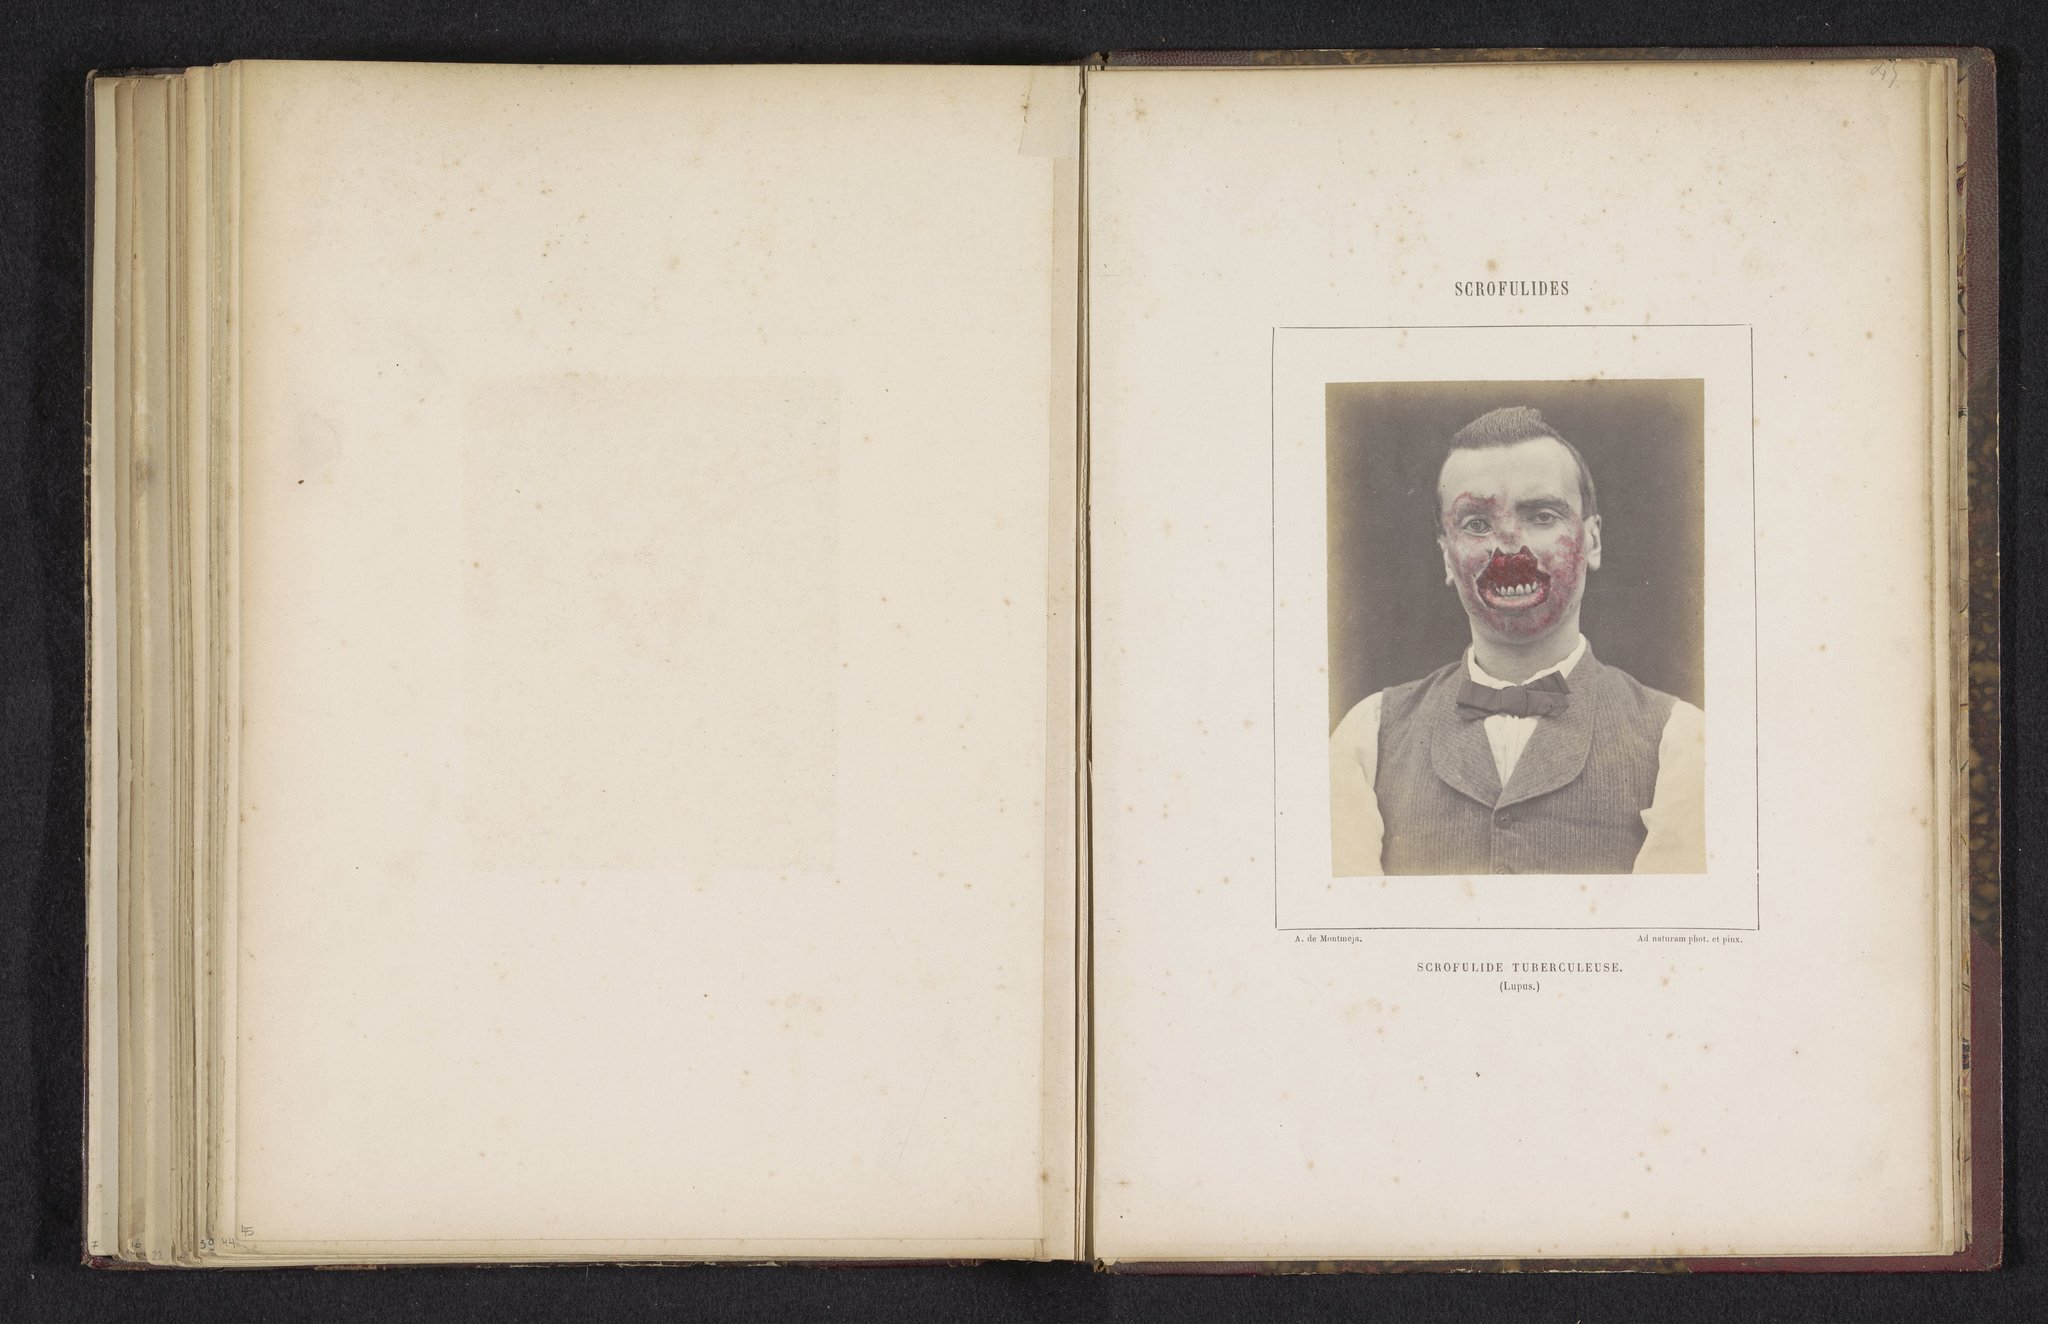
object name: page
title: Portret van een onbekende man met zweren in zijn gezicht en een missende neus en lip, mogelijk veroorzaakt door koningszeer en tuberculose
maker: a. de montméja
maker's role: arts, fotograaf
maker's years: 1841-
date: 1860-1868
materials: photographic support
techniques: albumen print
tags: skin and venereal diseases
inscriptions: inscription: ‘Scrofulides’, number: ‘45’, inscription: ‘Ad naturam phot. et pinx.’